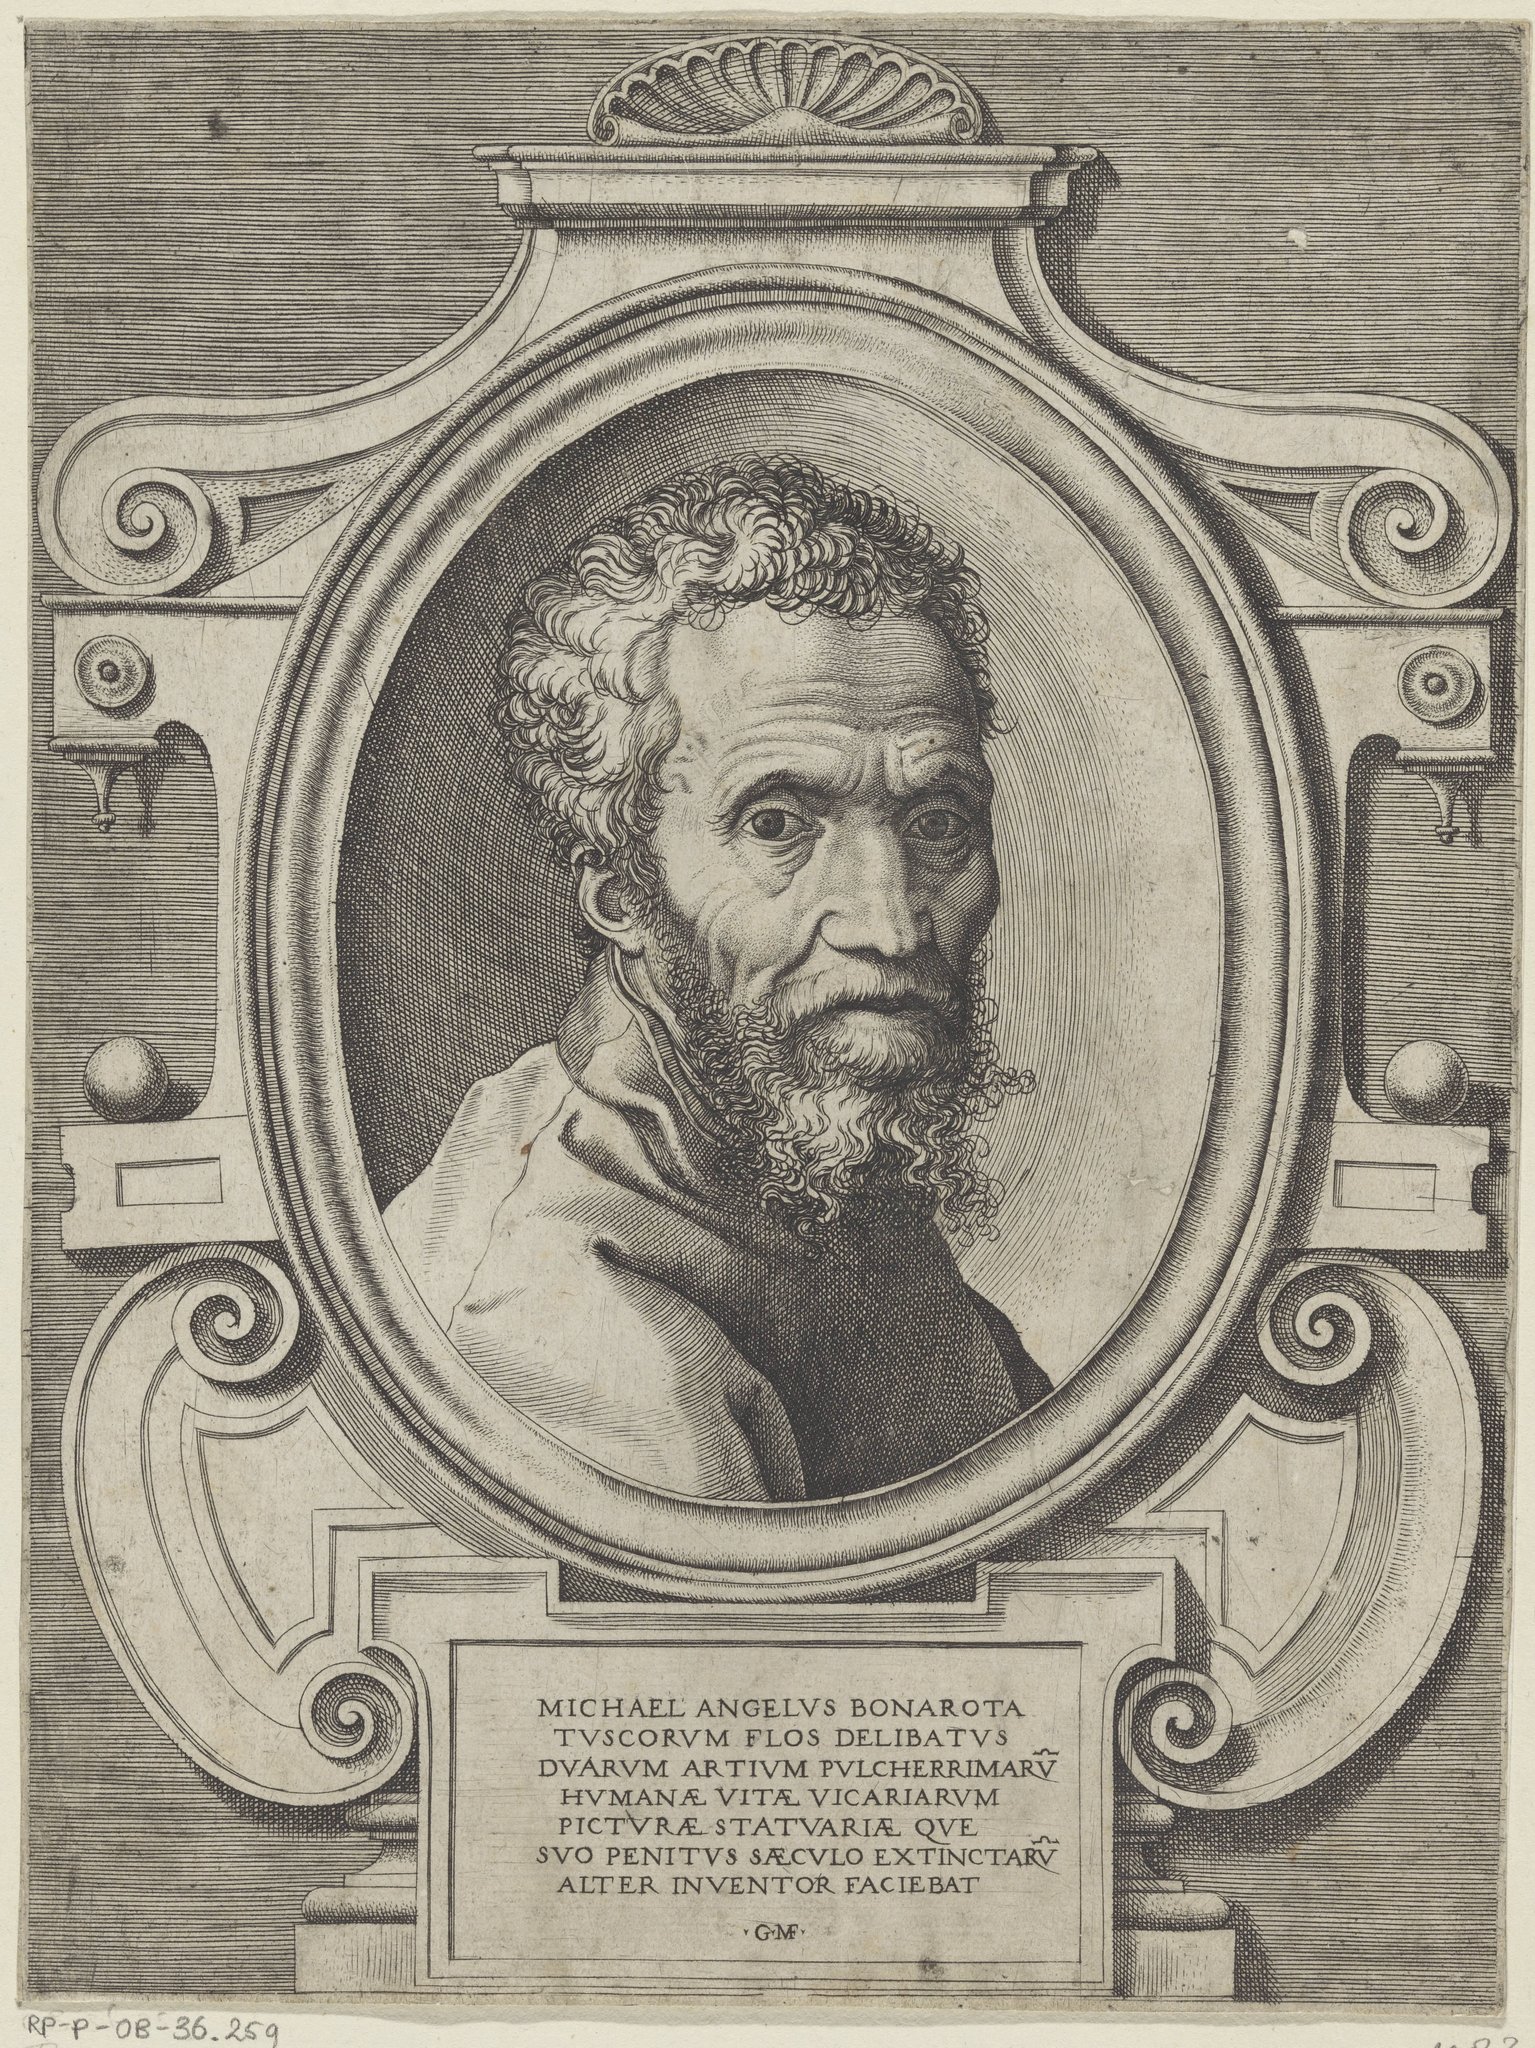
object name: print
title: Portret van kunstenaar Michelangelo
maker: giorgio ghisi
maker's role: print maker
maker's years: 1520-1582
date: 1530-1582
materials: paper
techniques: engraving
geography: italy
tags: rome, painter, draughtsman, sculptor, michelangelo, historical persons, portrait, self-portrait of artist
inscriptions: collector's mark: Lugt 240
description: Naar een portret door Marcello Venusti in Musei Capitolini te Rome.